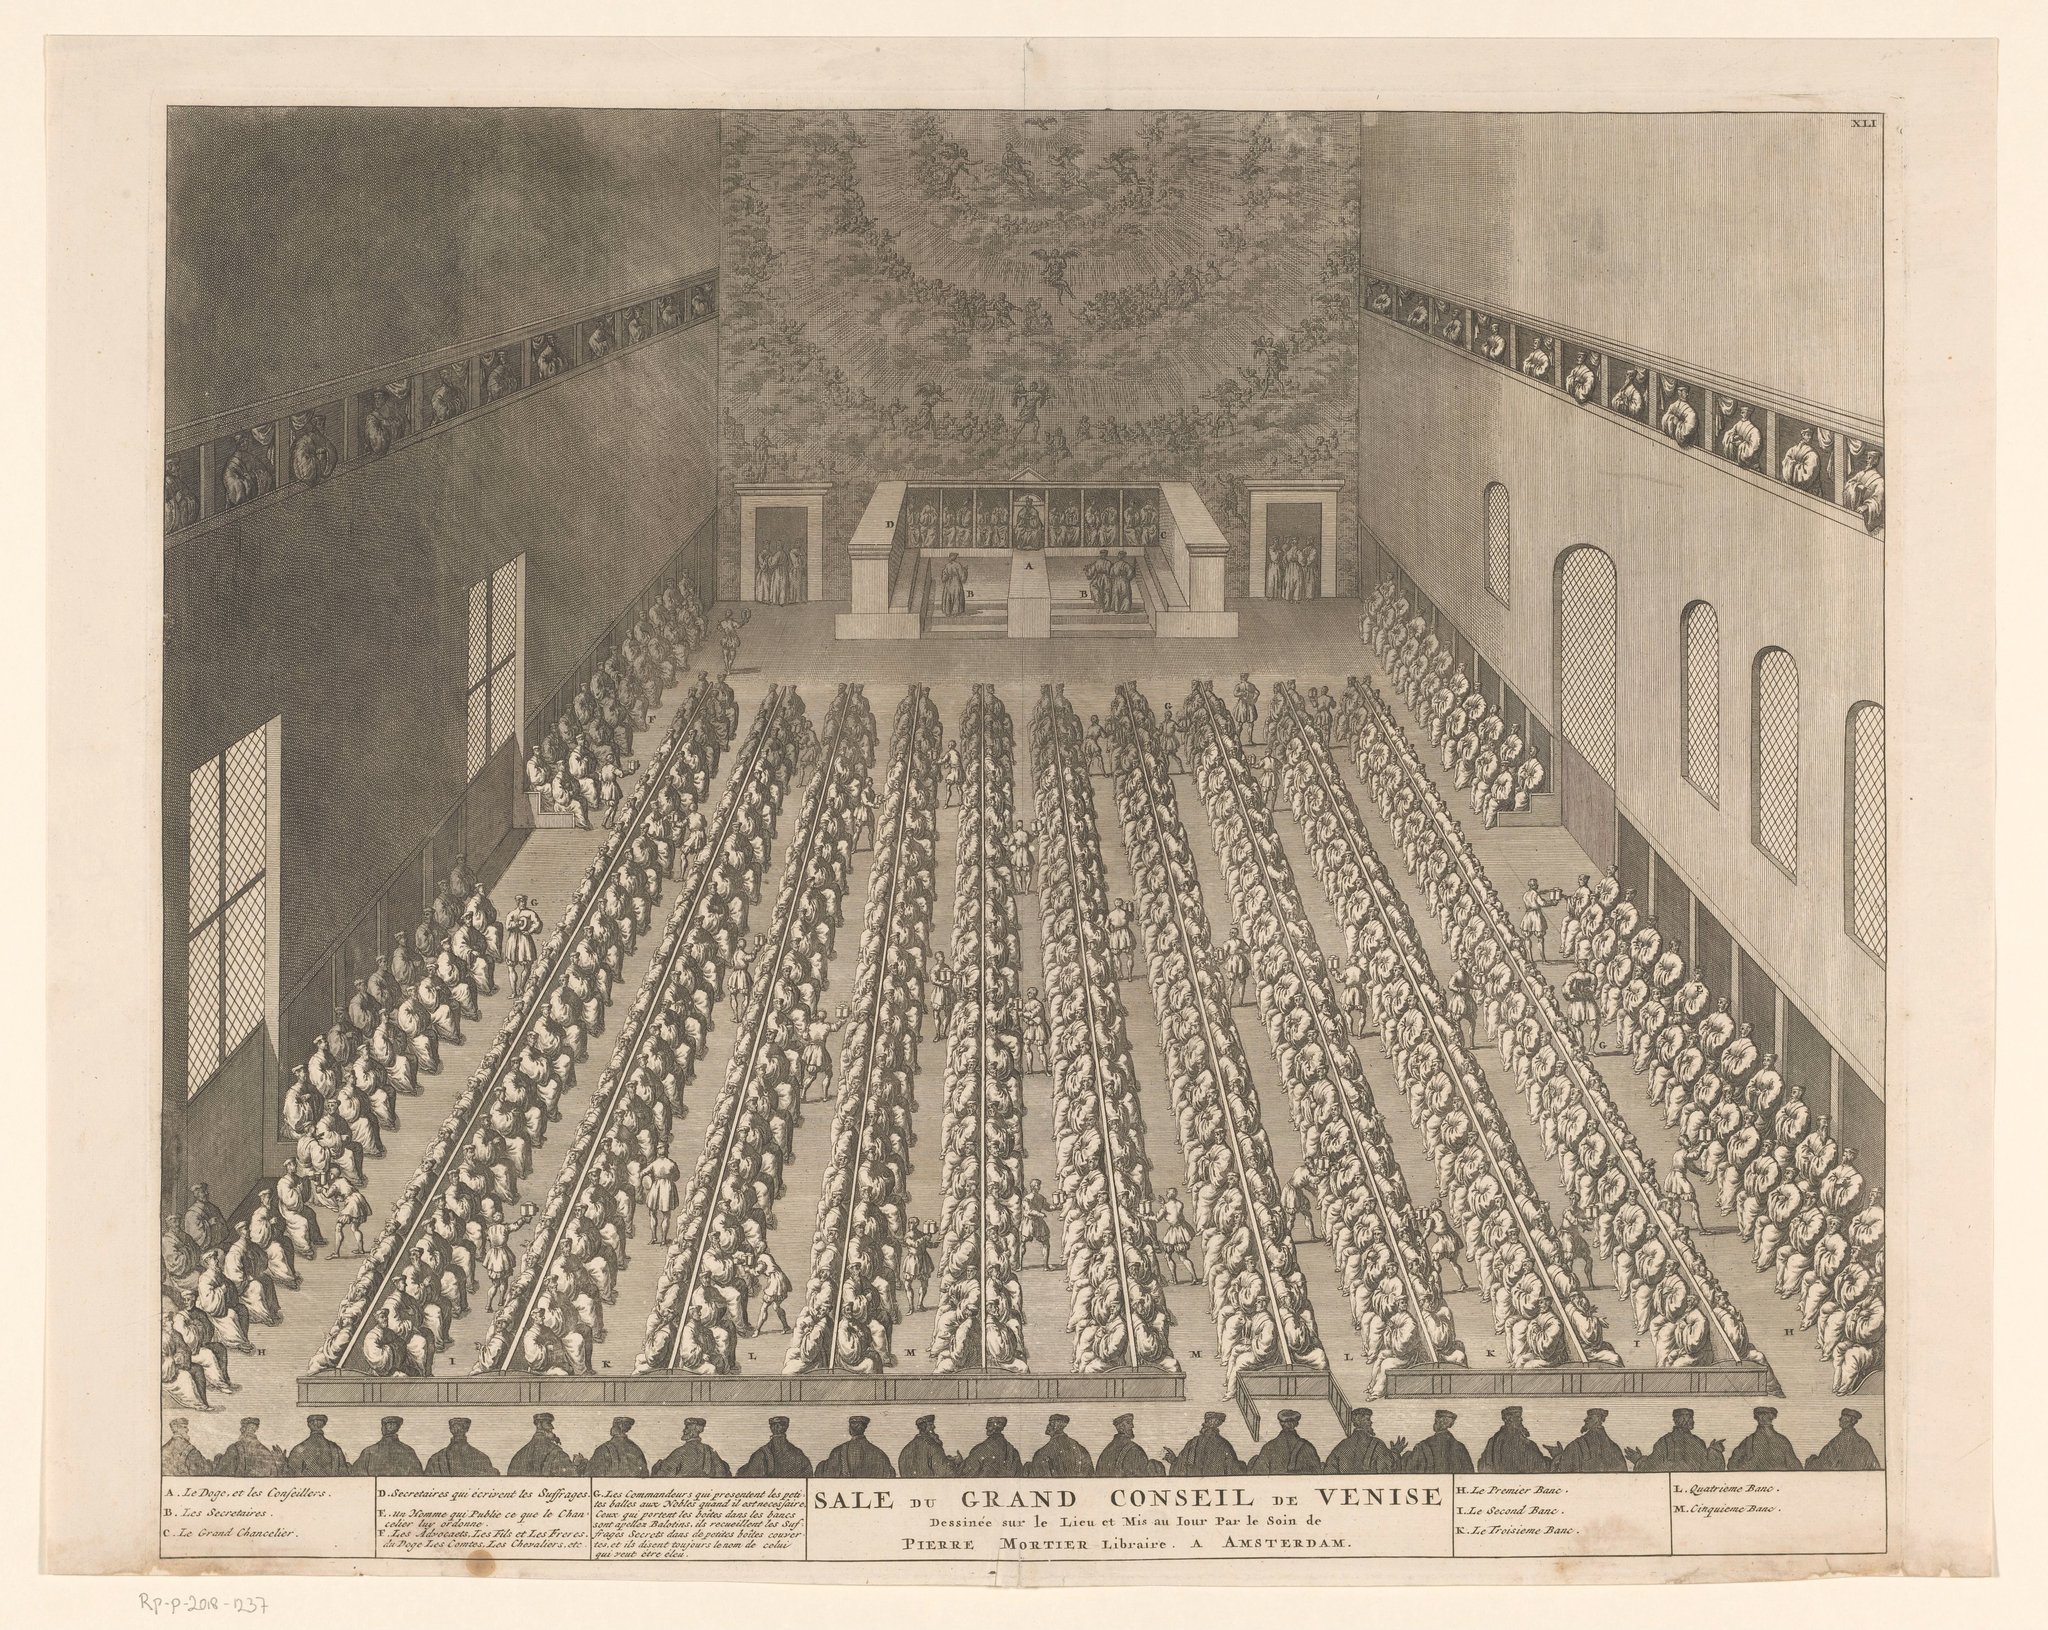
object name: print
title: Gezicht op de Maggior Consiglio in het Dogepaleis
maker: Anonymous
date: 1704-1724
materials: paper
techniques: engraving, etching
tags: city council, voting, election, palace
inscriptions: collector's mark: Lugt 2228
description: Gezicht op de Maggior Consiglio, ook wel Consilium Sapientium genoemd, in het Dogepaleis of Palazzo Ducale. In de zaal worden de stemmen voor een verkiezing opgehaald. Rechtsboven genummerd: XLI.